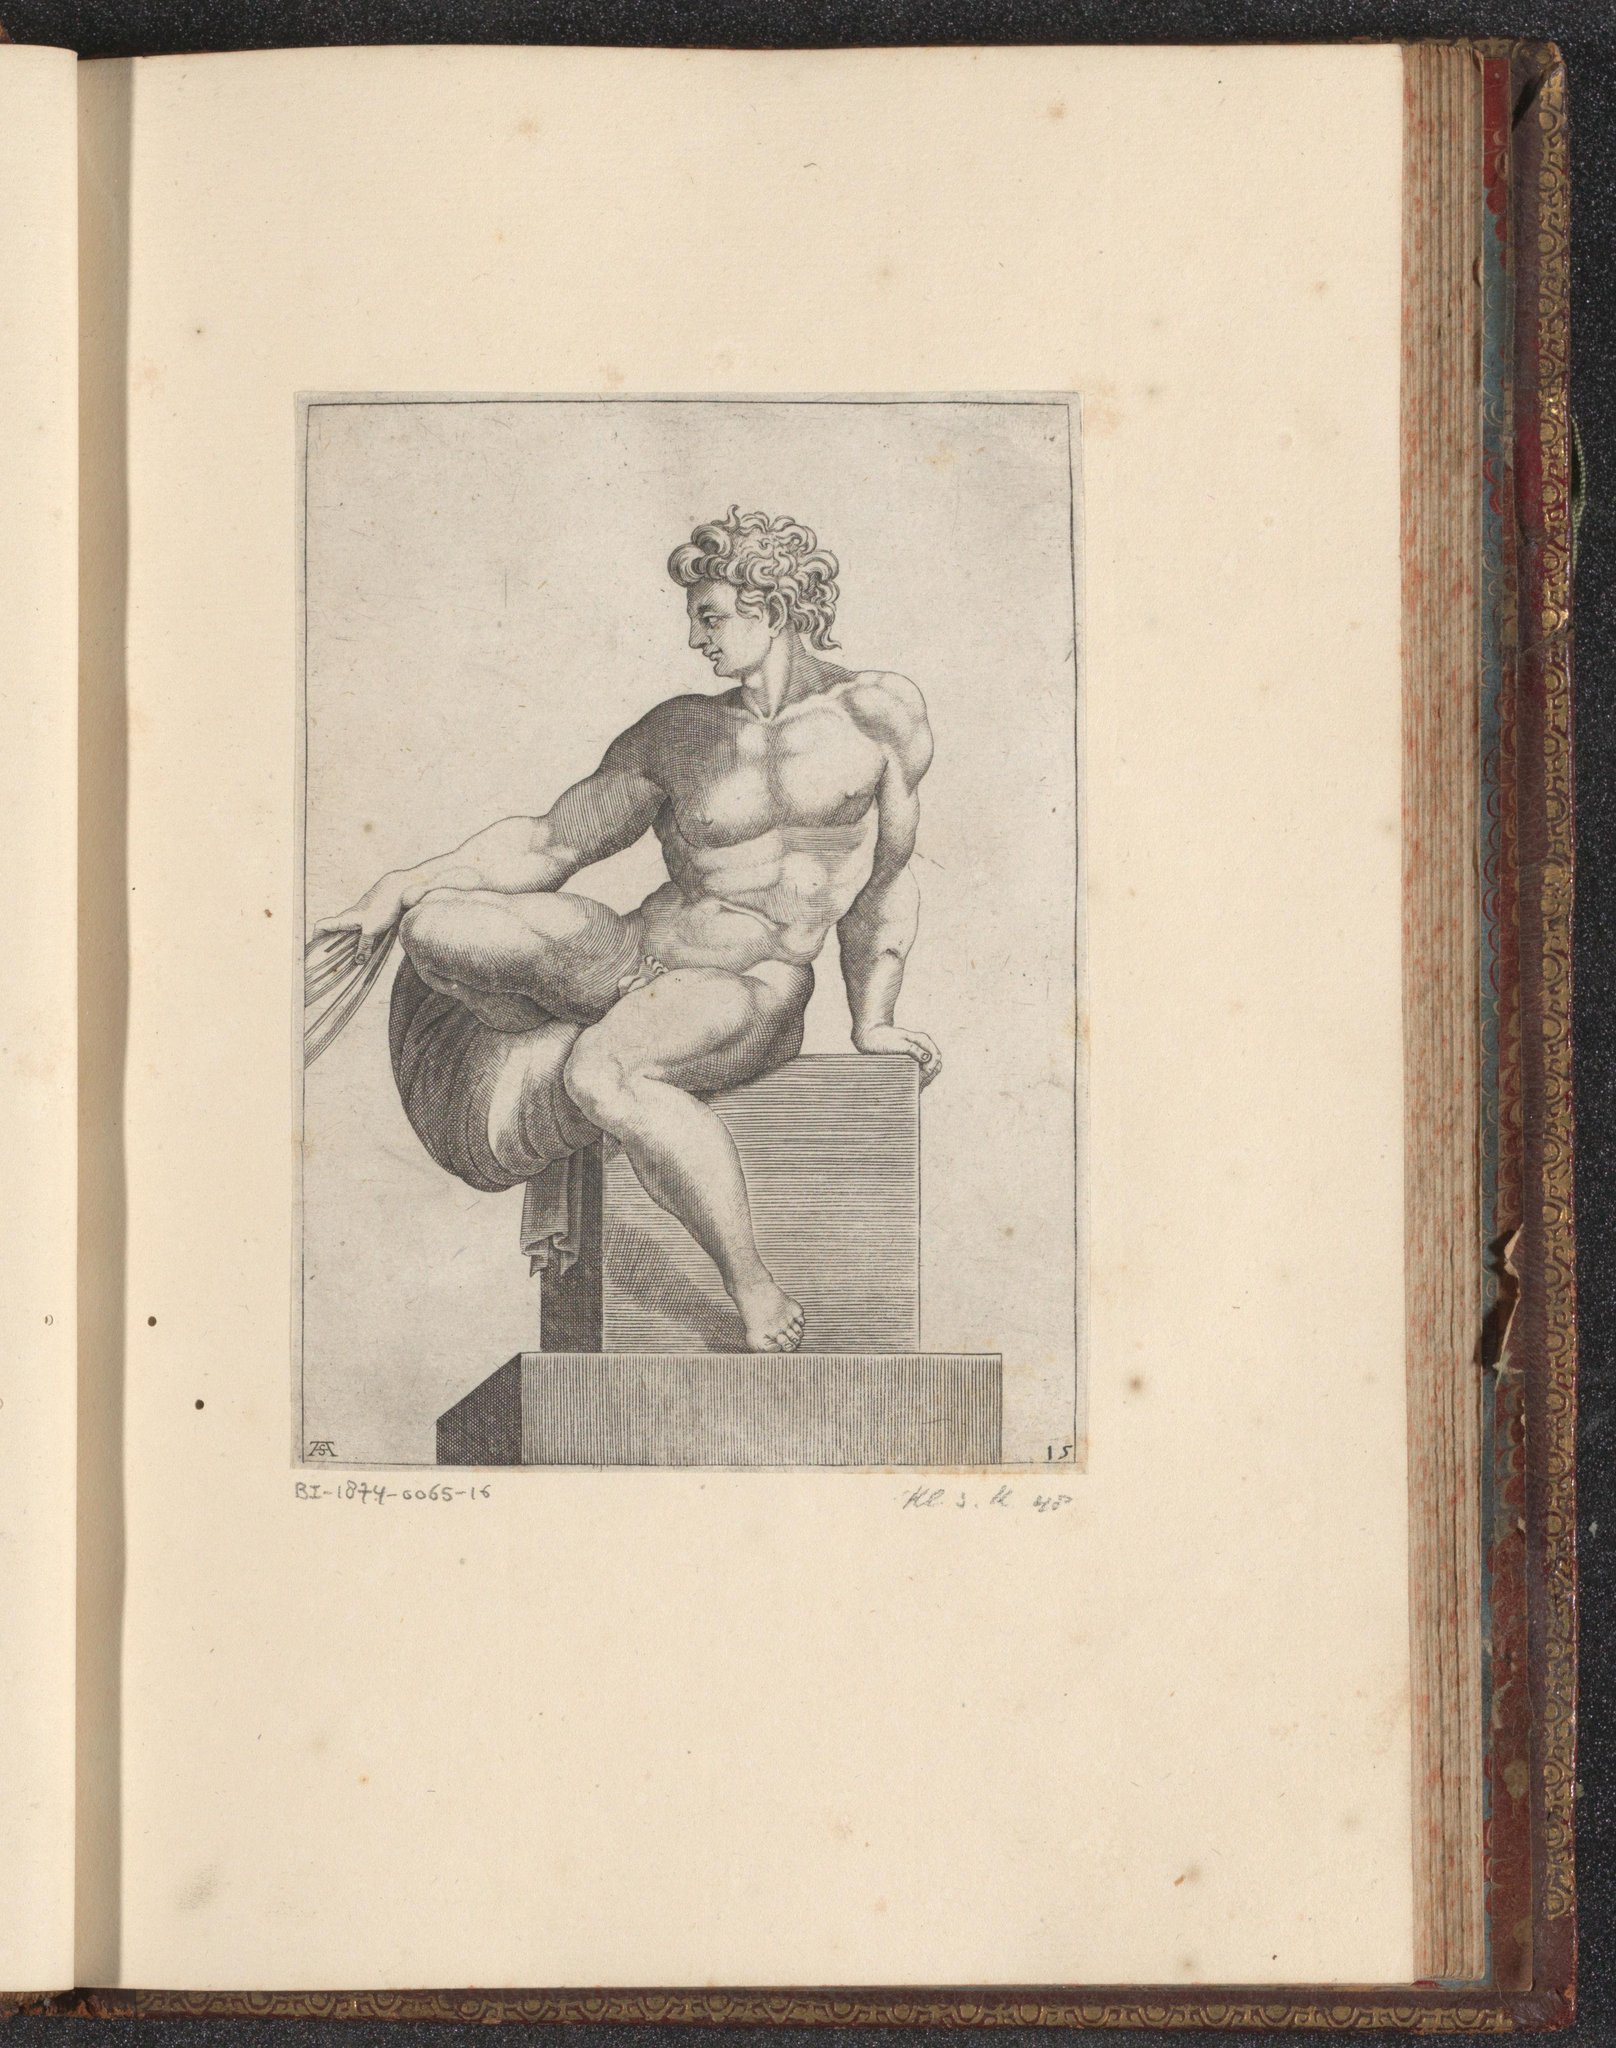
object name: album leaf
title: Schilderingen in de Sixtijnse kapel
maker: adamo scultori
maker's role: painter, print maker, sculptor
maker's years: 1530-1585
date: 1585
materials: paper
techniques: engraving, intaglio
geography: italy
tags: the (nude) human figure; 'corpo humano' (ripa)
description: Zittende naakte man, naar links gedraaid. Eén van de 'ignudi' (naakte mannen) van Michelangelo's plafondschildering. Genummerd rechtsonder: 15. De prent maakt deel uit van een album.